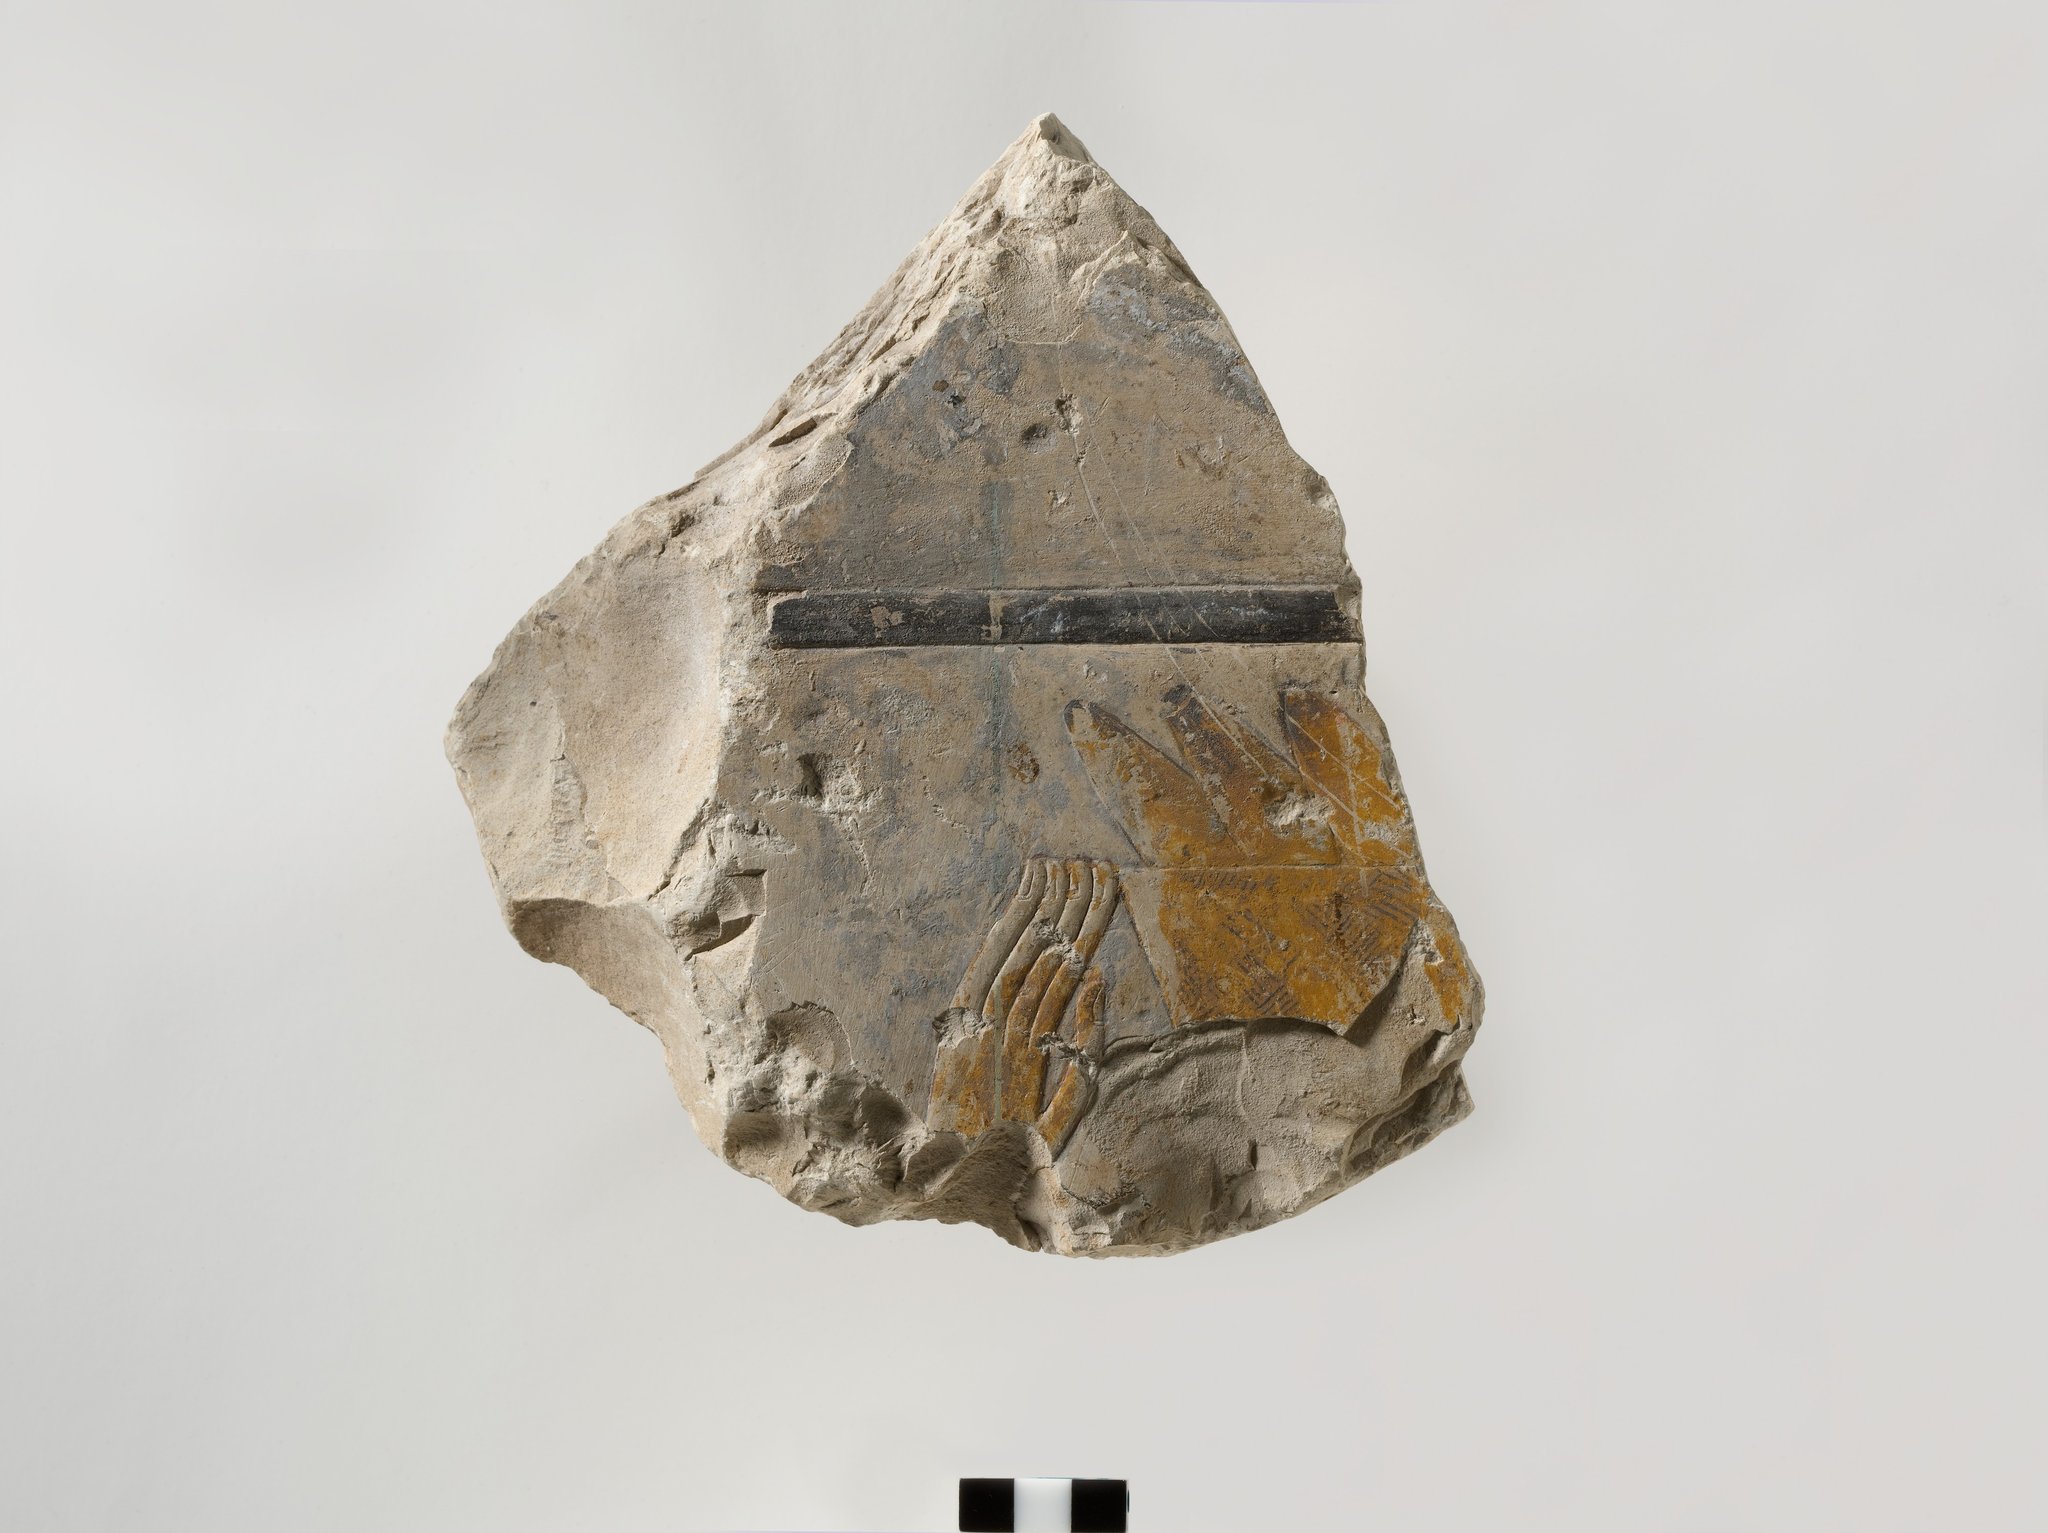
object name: relief fragment, tomb of meketre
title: Relief fragment from the tomb of Meketre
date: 1981-1975 BCE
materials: limestone, paint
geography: egypt